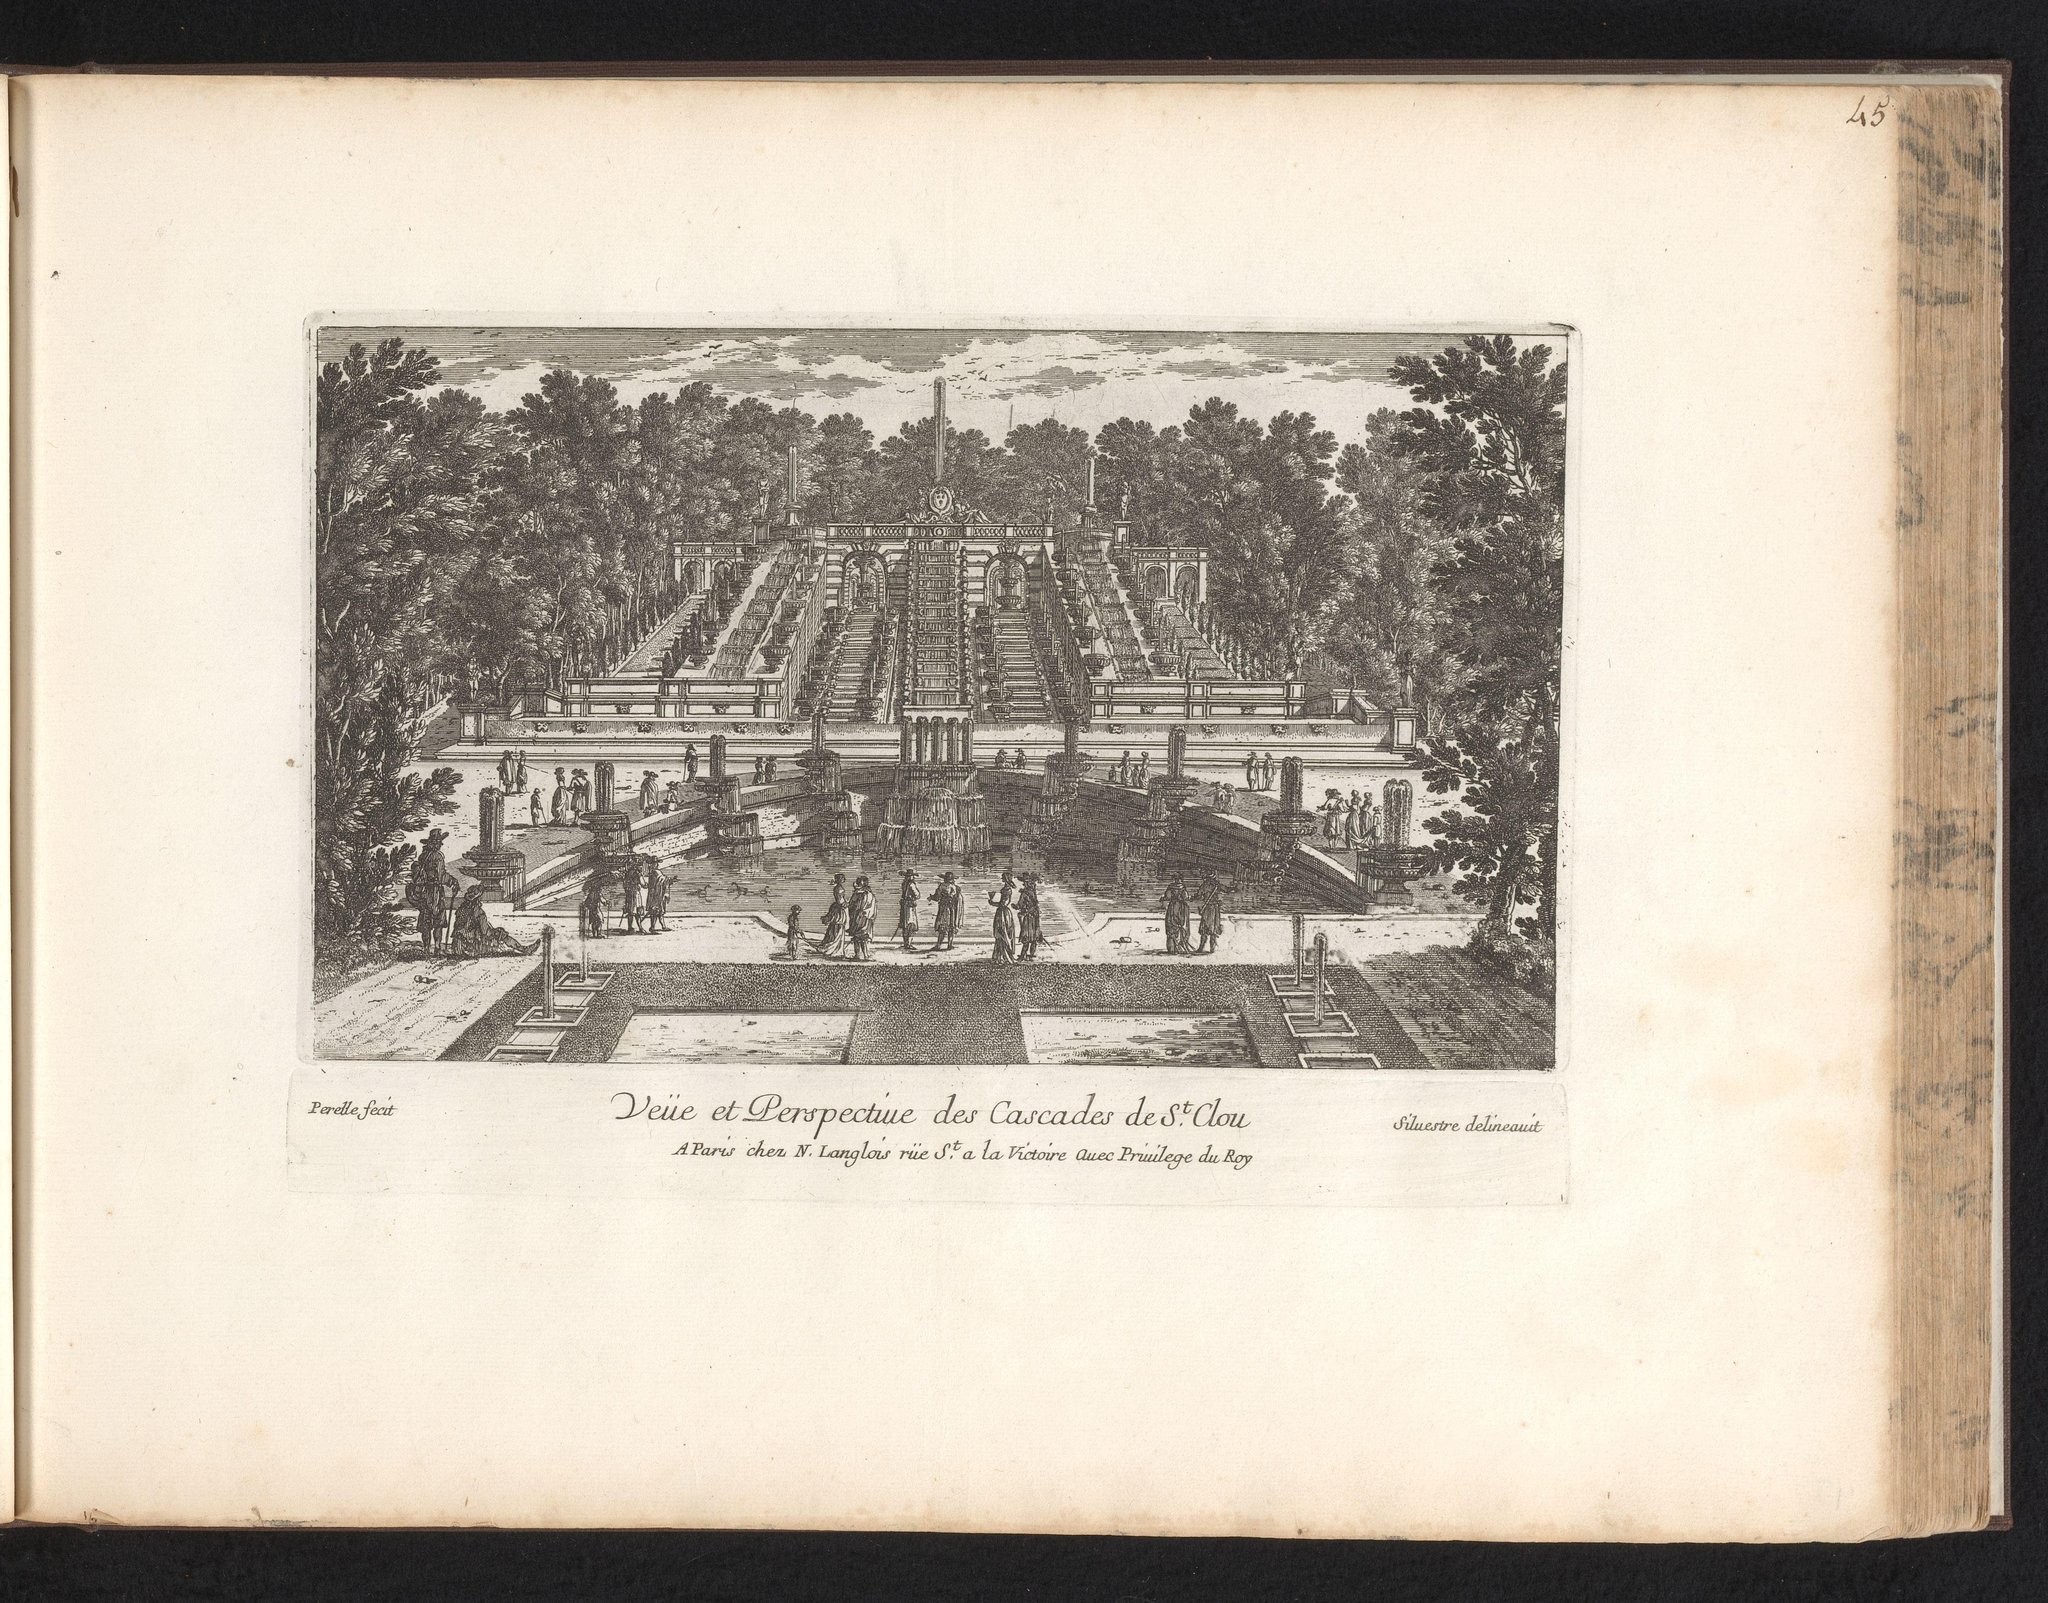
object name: album leaf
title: Gezicht op de watervallen van Saint-Cloud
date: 1613-1707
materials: paper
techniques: etching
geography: france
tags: castle, landscape with tower or castle, garden cascade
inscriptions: collector's mark: Lugt 2228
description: Prenten met het signatuur 'Perelle' kunnen zowel door vader Gabriel als door zonen Nicolas en Adam gemaakt zijn. De uitgevers vader en zoon Nicolas Langlois worden allebei vermeld als N. Langlois op hetzelfde adres.